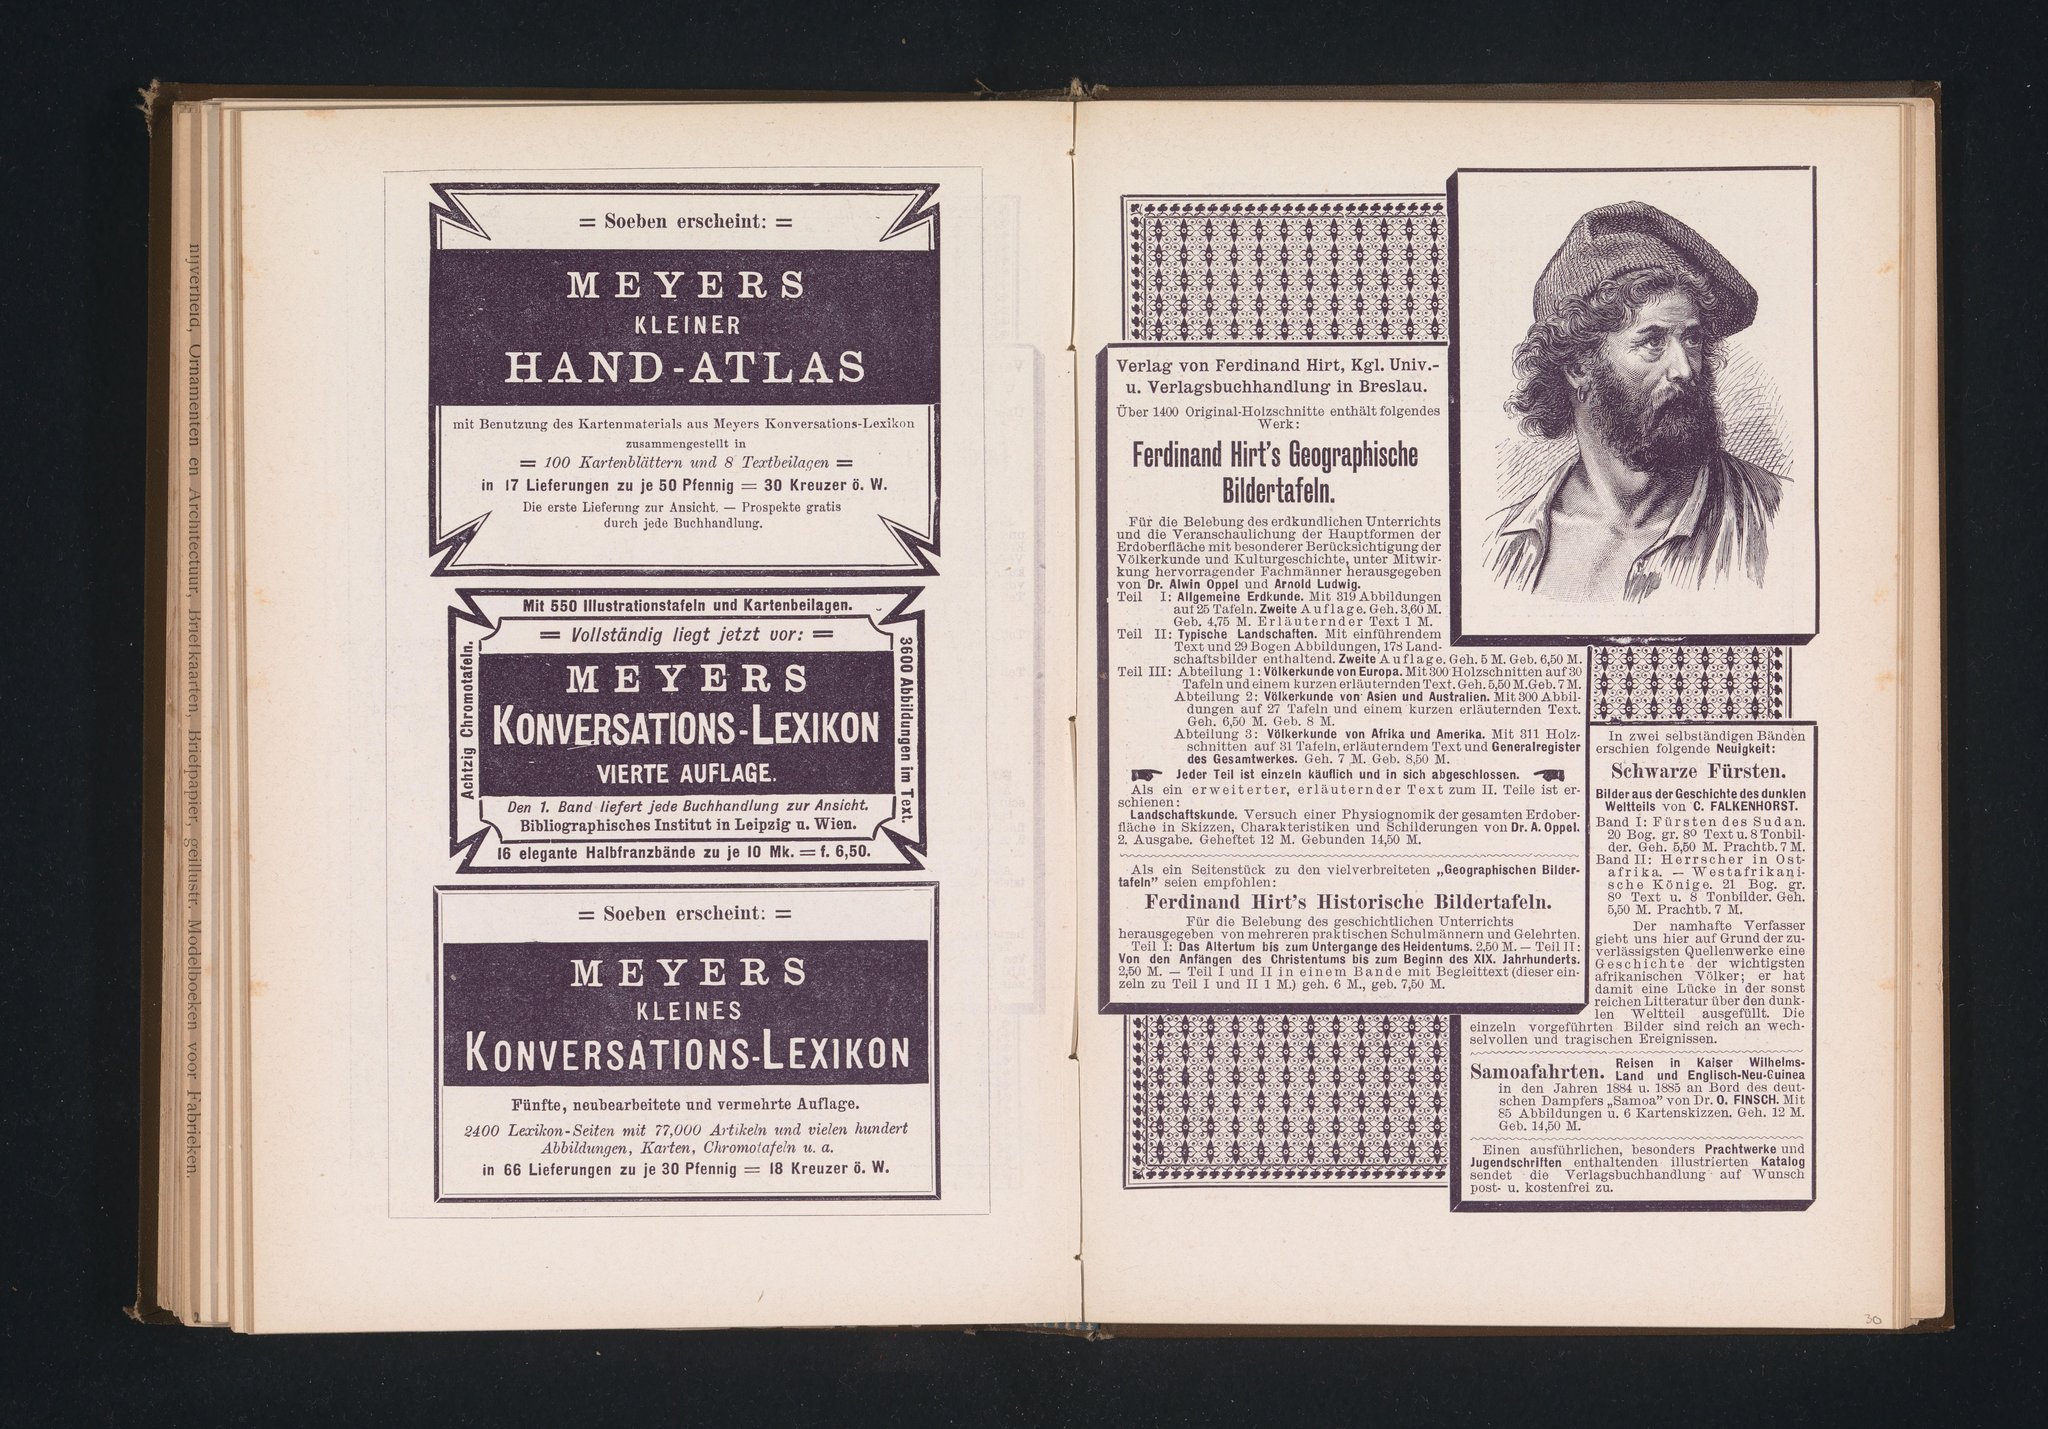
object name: reproduction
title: Reproductie van een gravure van een portret van een onbekende man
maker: Anonymous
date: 1887-1892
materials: paper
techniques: printing block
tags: historical persons not known by name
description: Prent in katern advertenties achterin boek. Prent is onderdeel van een reclameboodschap van Ferdinand Hirt's Geographische Bildertafeln.